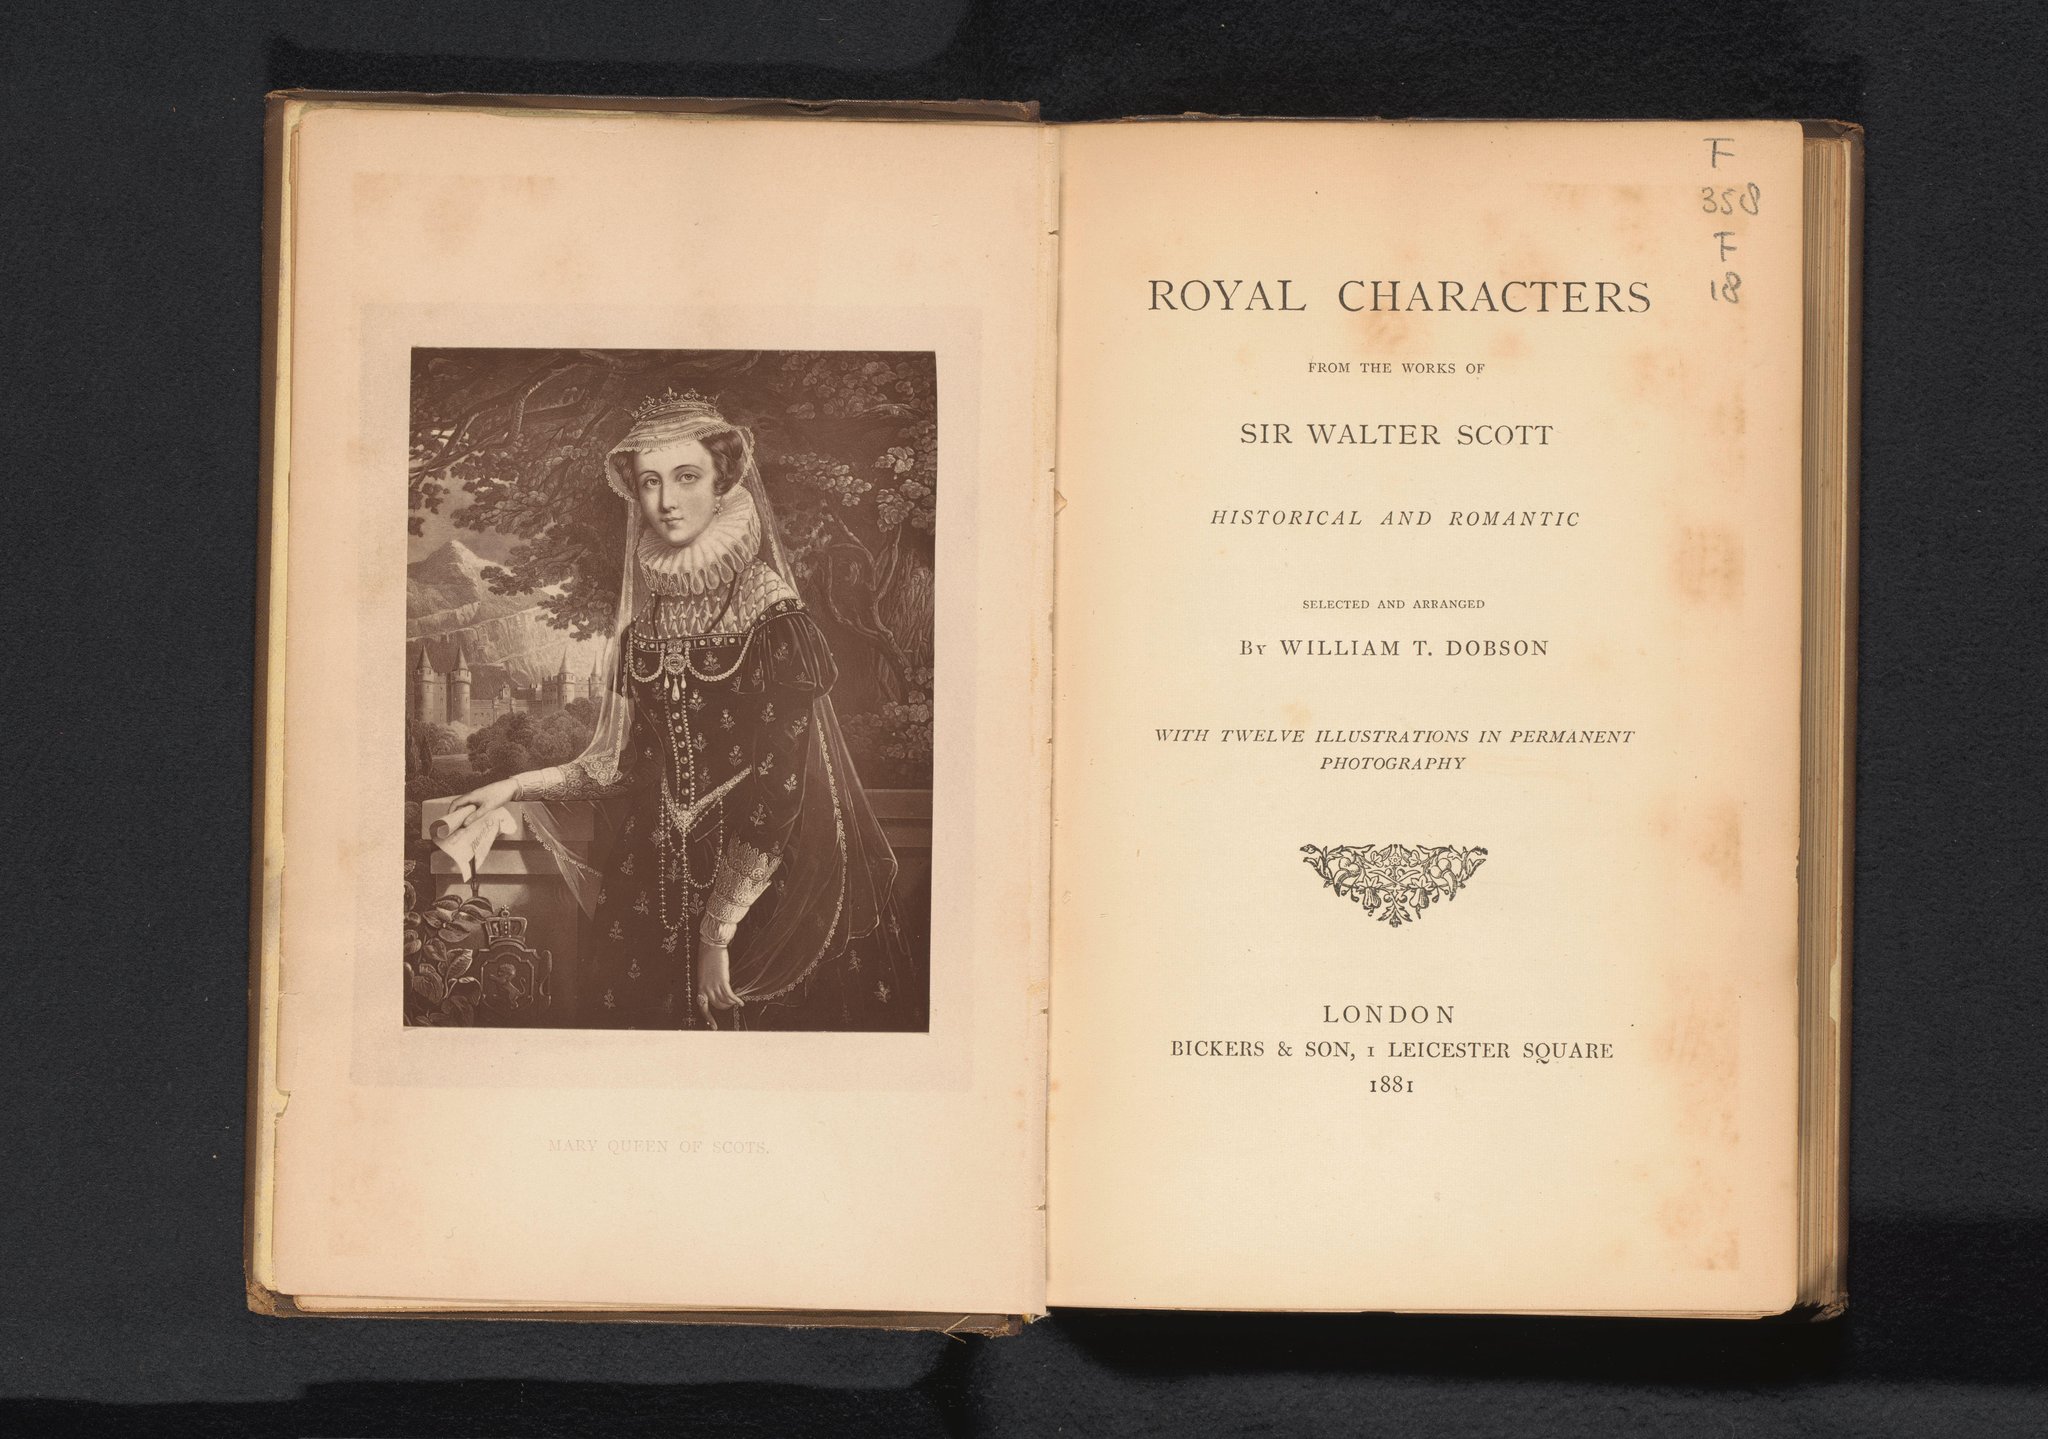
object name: photomechanical print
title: Mary Queen of Scots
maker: Anonymous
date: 1876-1881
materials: paper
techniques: woodburytype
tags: queen